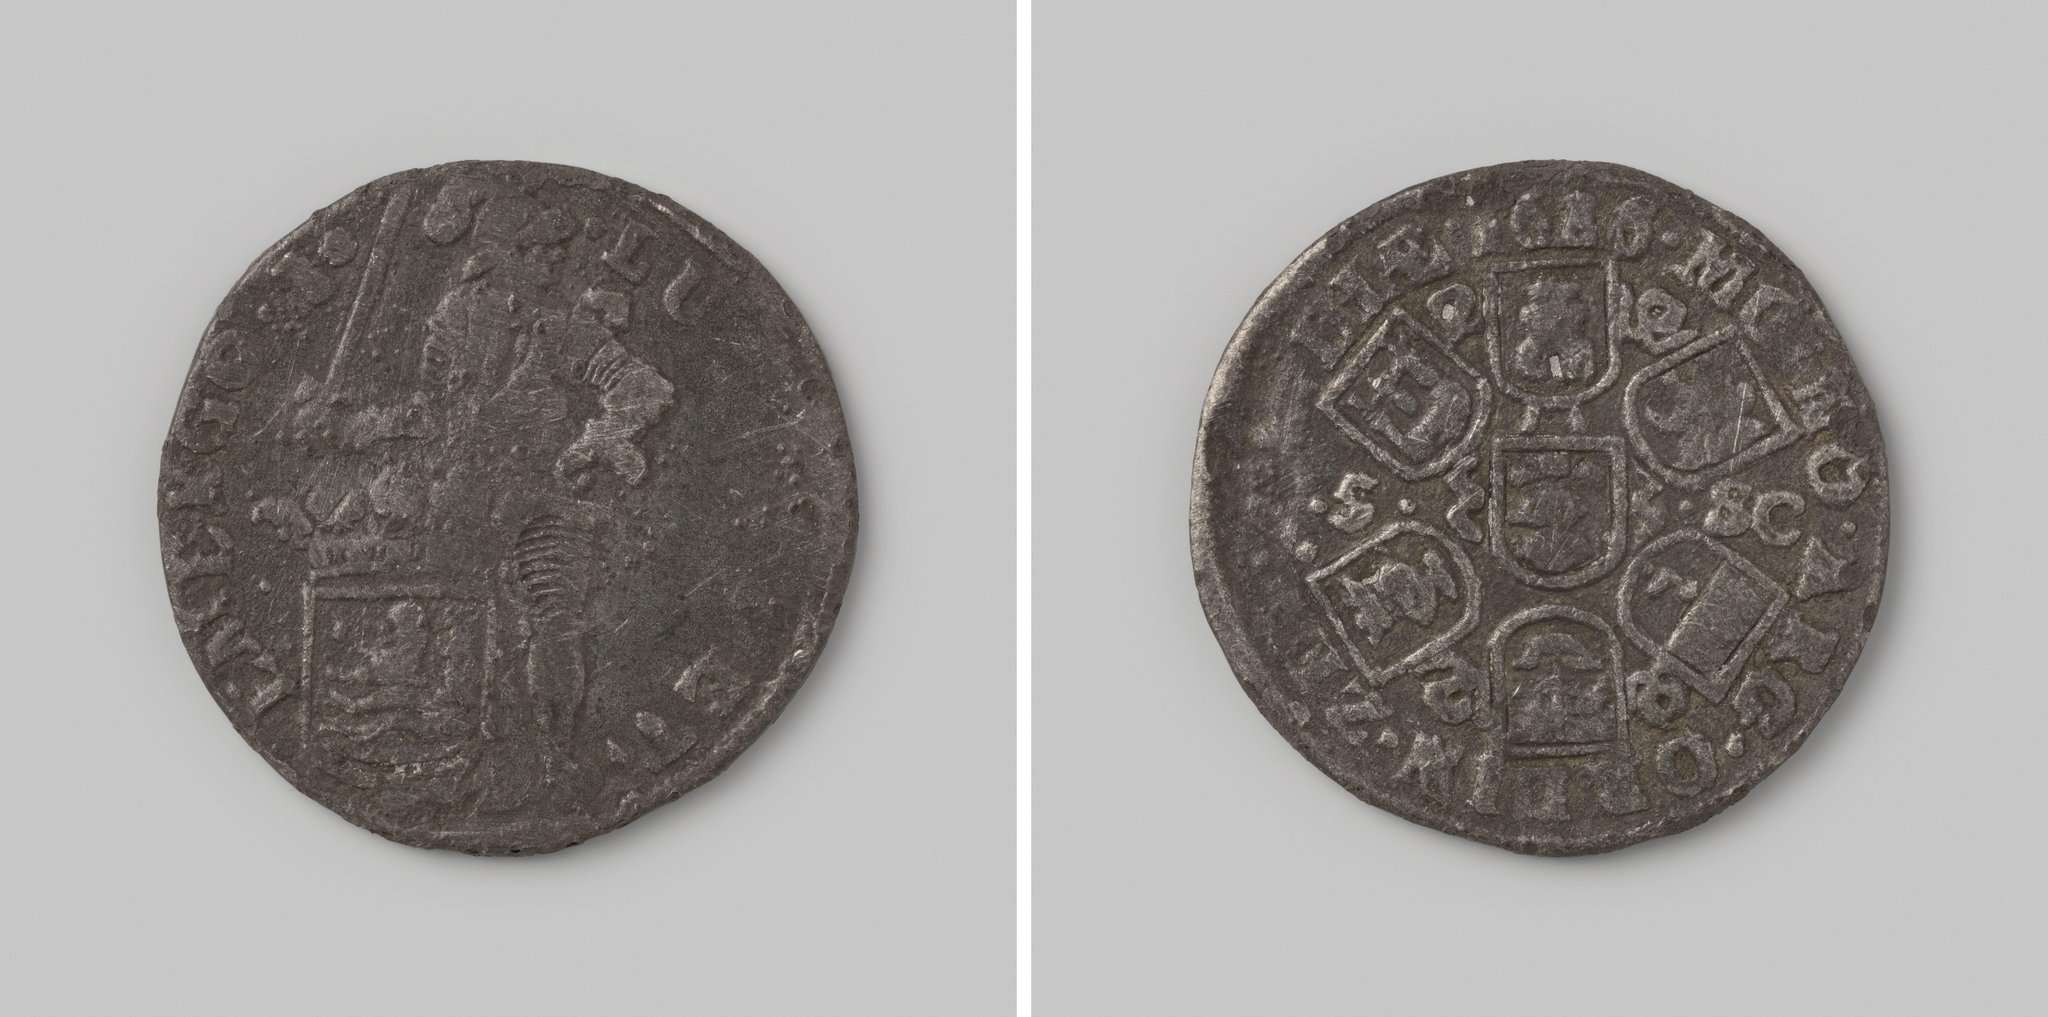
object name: coin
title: Zeeland, derde daalder van 20 groot, 1686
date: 1686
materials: lead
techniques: casting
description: Valse Zeeuwse daalder van lood. Voorzijde: staande ridder met in rechterhand zwaard en voor zich gekroond wapenschild van Zeeland. Keerzijde: versierd wapenschild met wapens van Zeeuwse steden en de eerste edele met links en rechts van dat wapenschild waarde-aanduiding 5 SC. Jaartal in omschrift bovenaan. Vervalsing in lood, ontdekt bij hermunting in 1843.